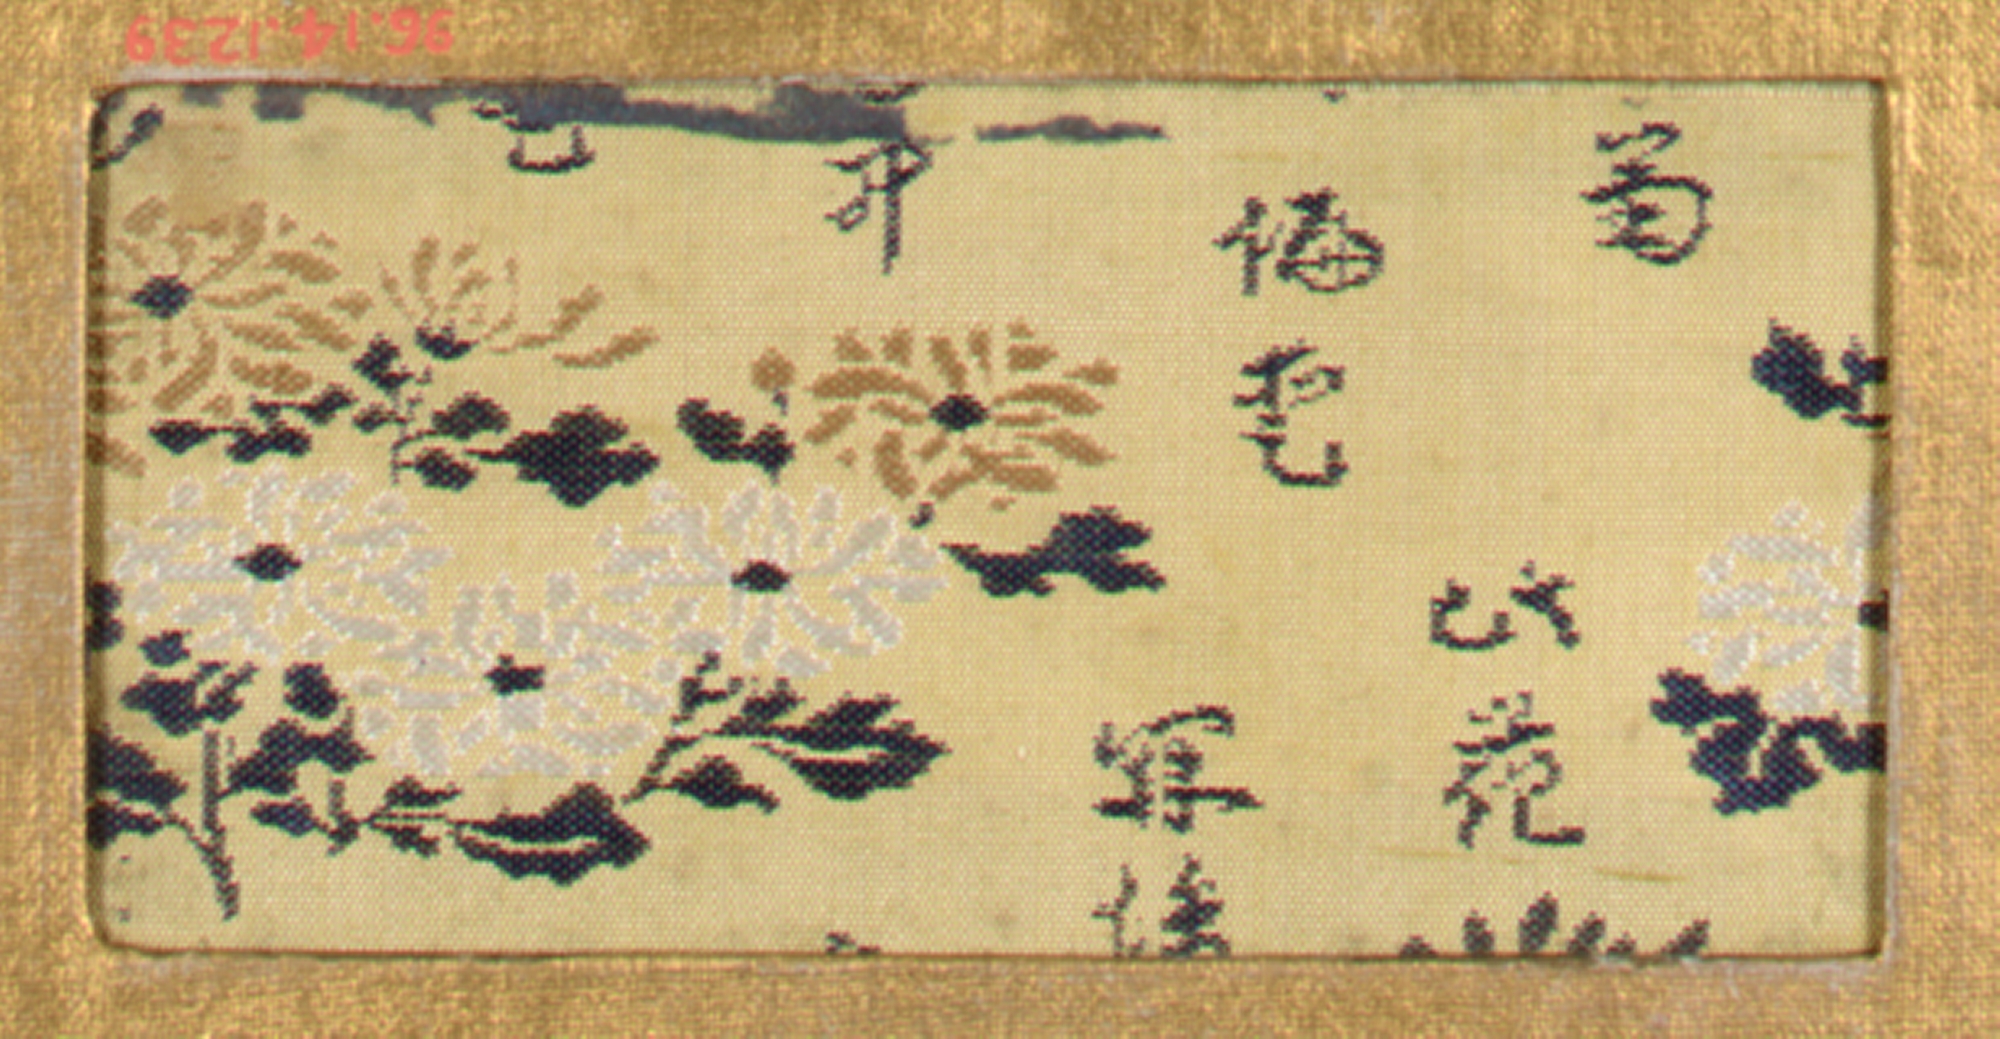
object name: piece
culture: japanese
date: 1701-1900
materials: silk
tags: flowers